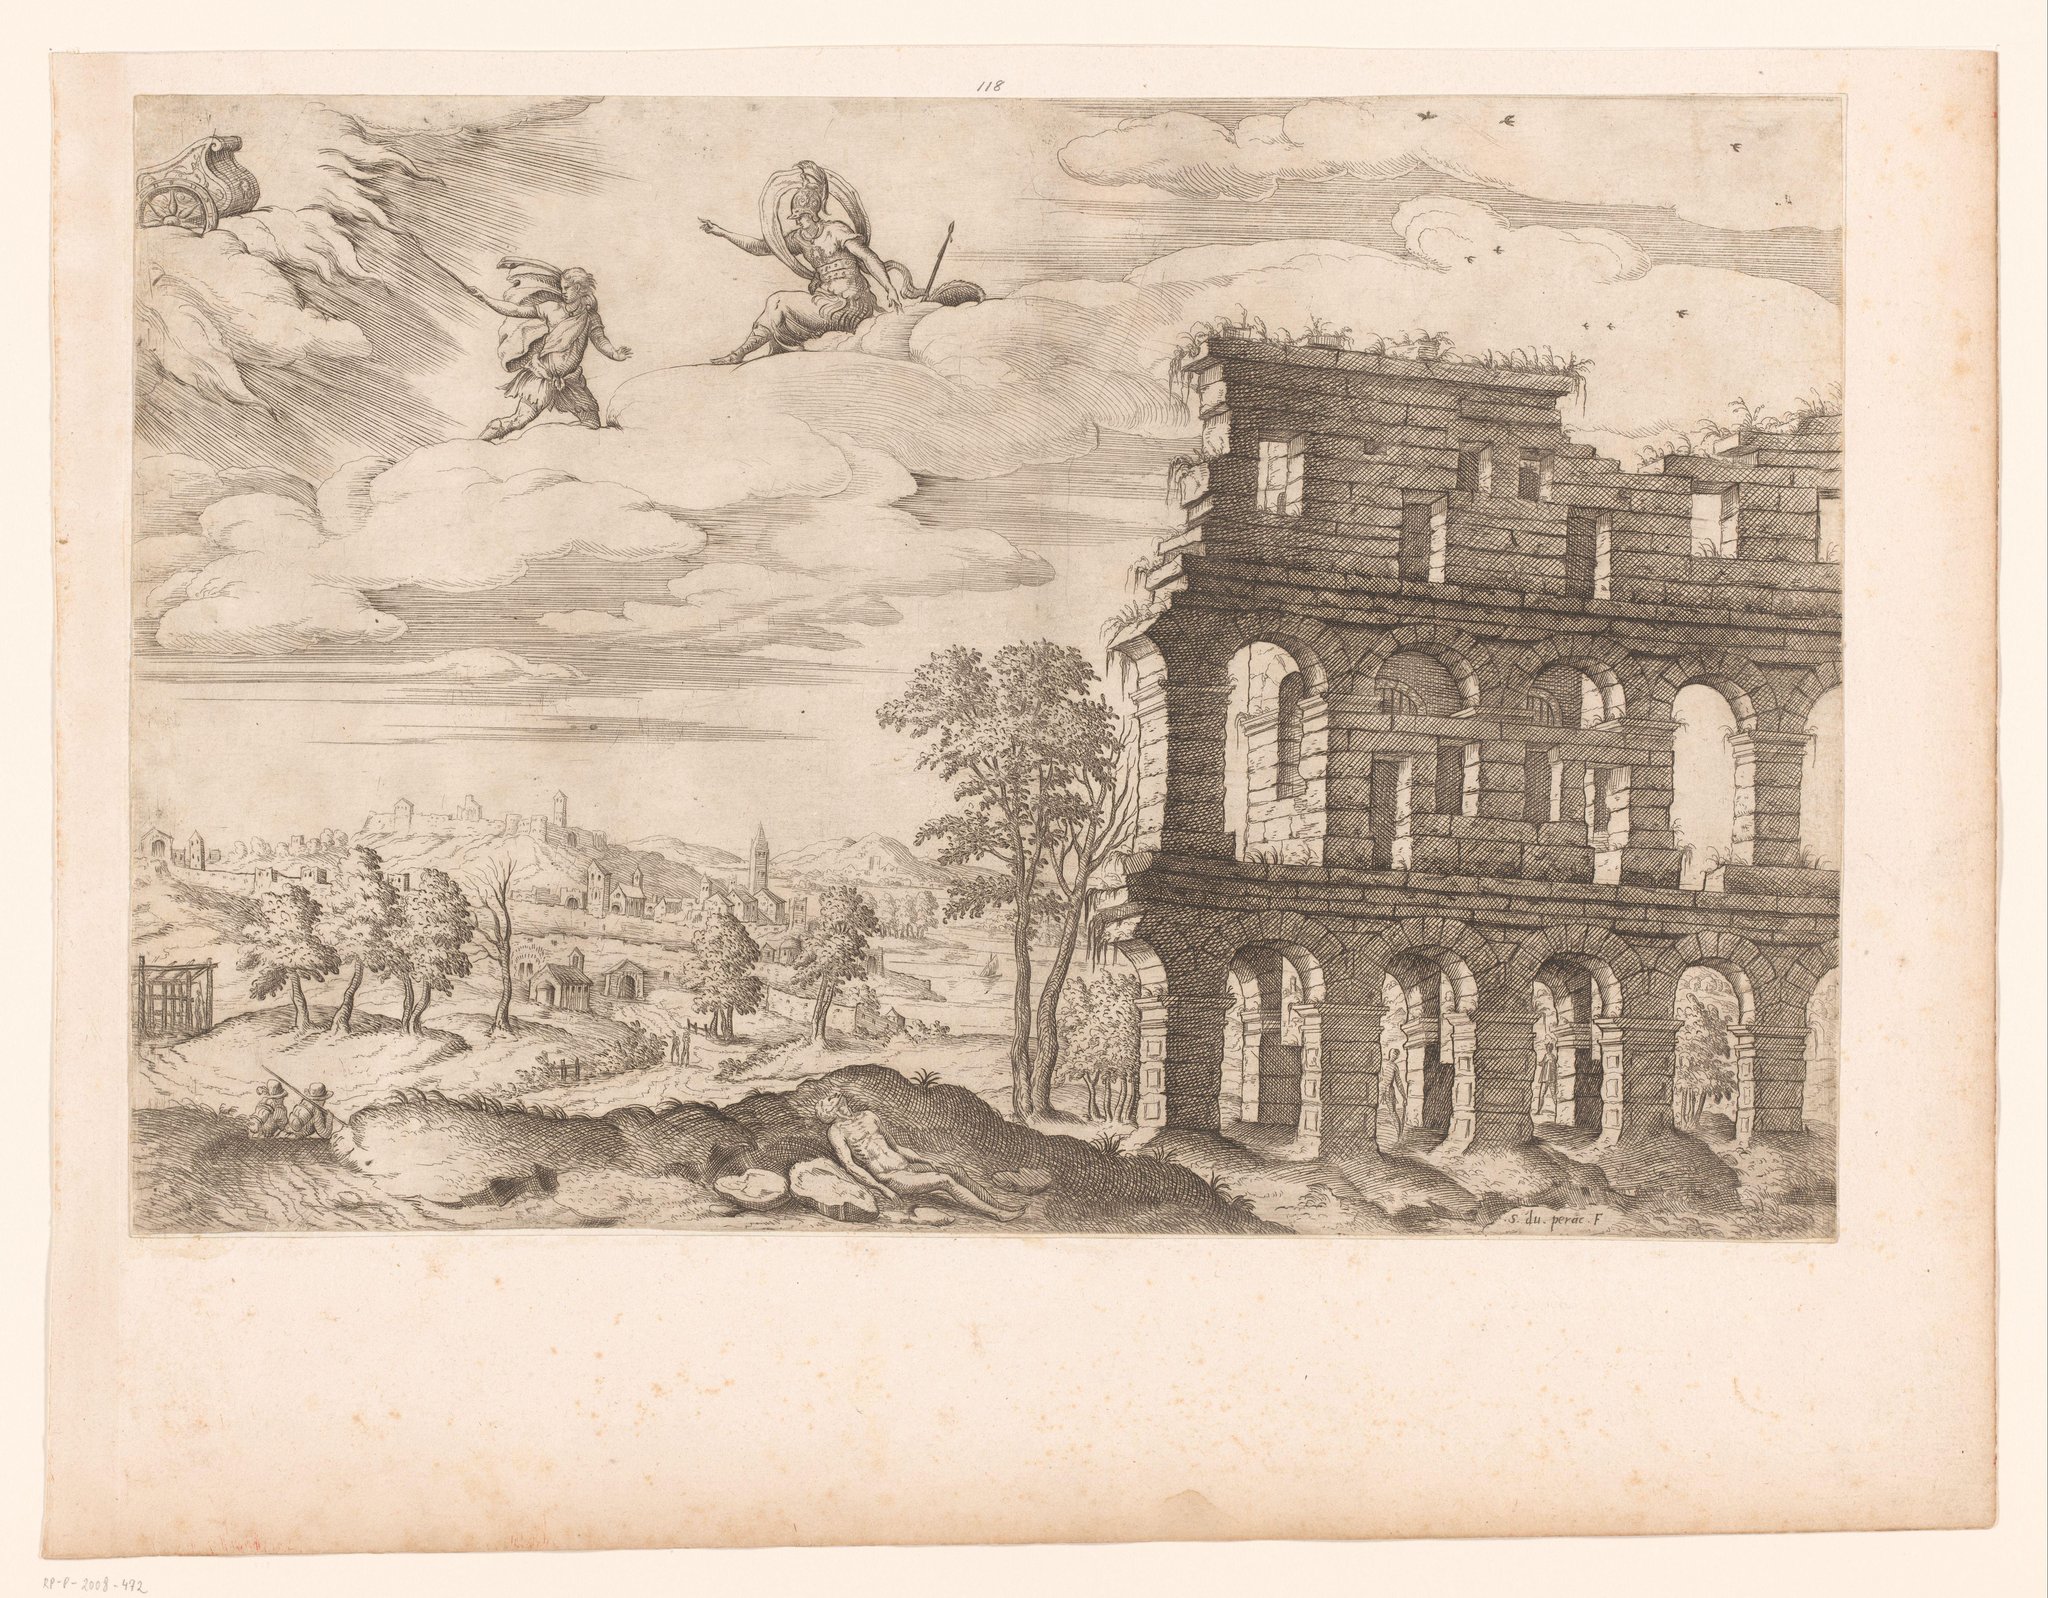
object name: print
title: Prometheus steelt het vuur na het boetseren van de mens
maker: etienne dupérac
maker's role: draughtsman, painter, print maker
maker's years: 1525-1604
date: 1535-1604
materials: paper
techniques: engraving, etching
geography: france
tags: prometheus brings fire to mankind, prometheus as the first sculptor, landscape with ruins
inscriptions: collector's mark: Lugt 2760, collector's mark: Lugt 2228